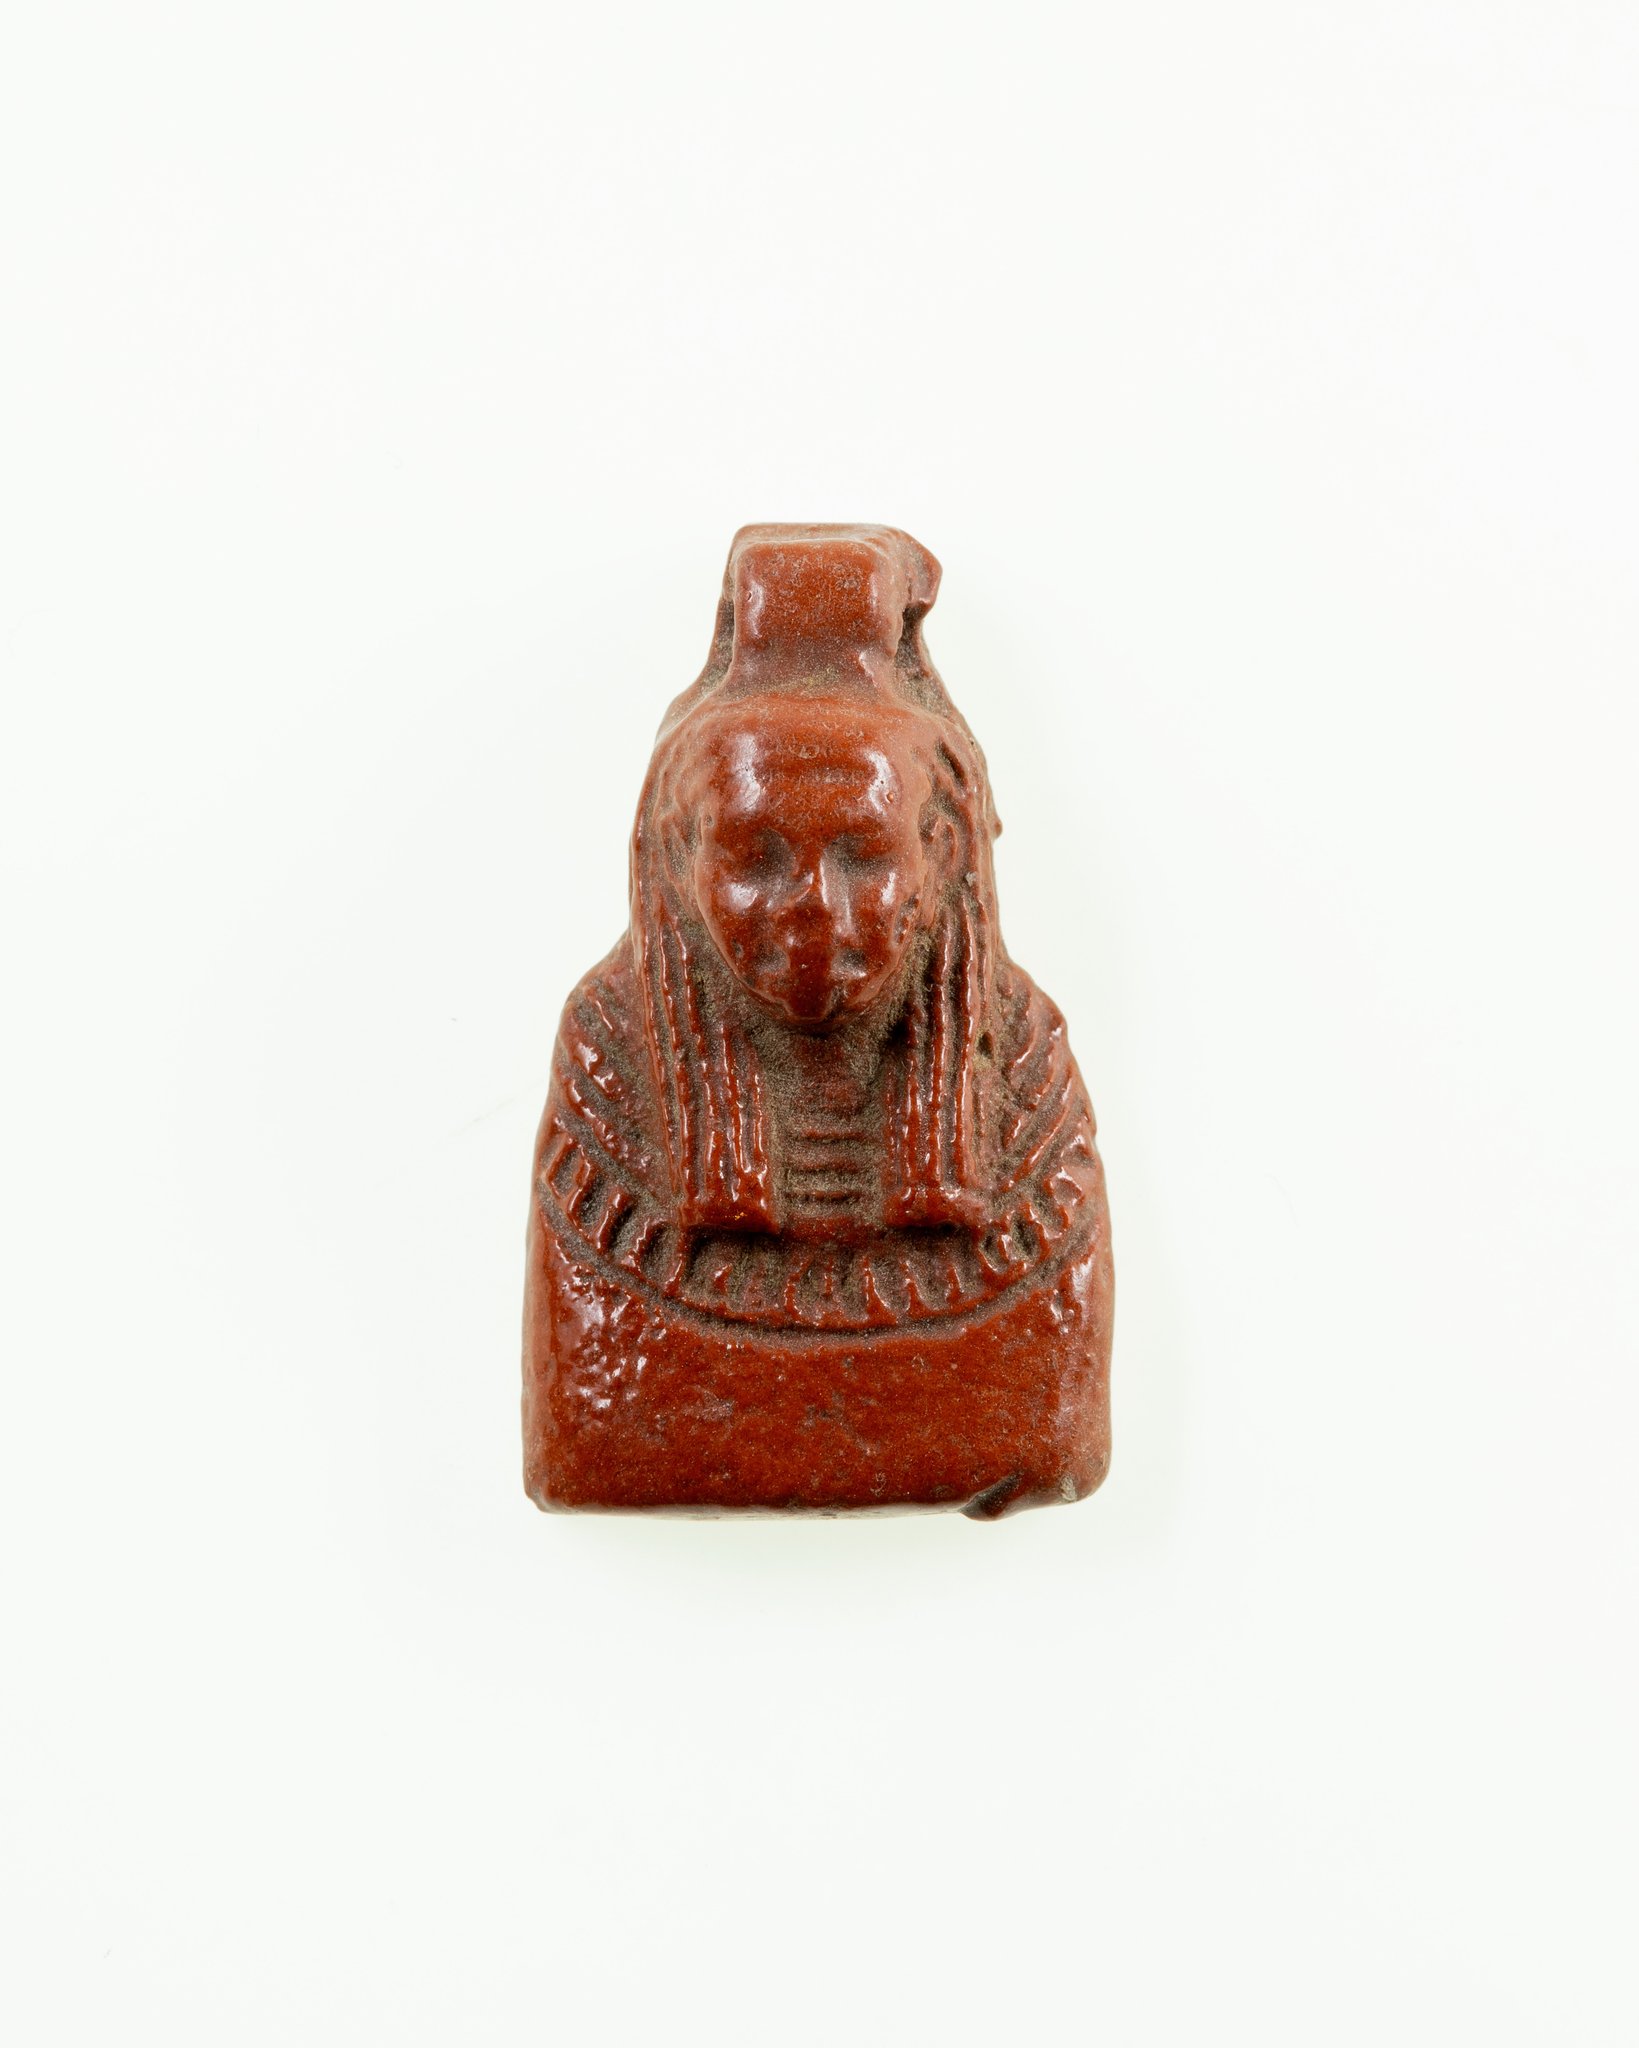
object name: amulet, ancestor bust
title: Ancestor bust amulet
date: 1295-1185 BCE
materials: faience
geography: egypt